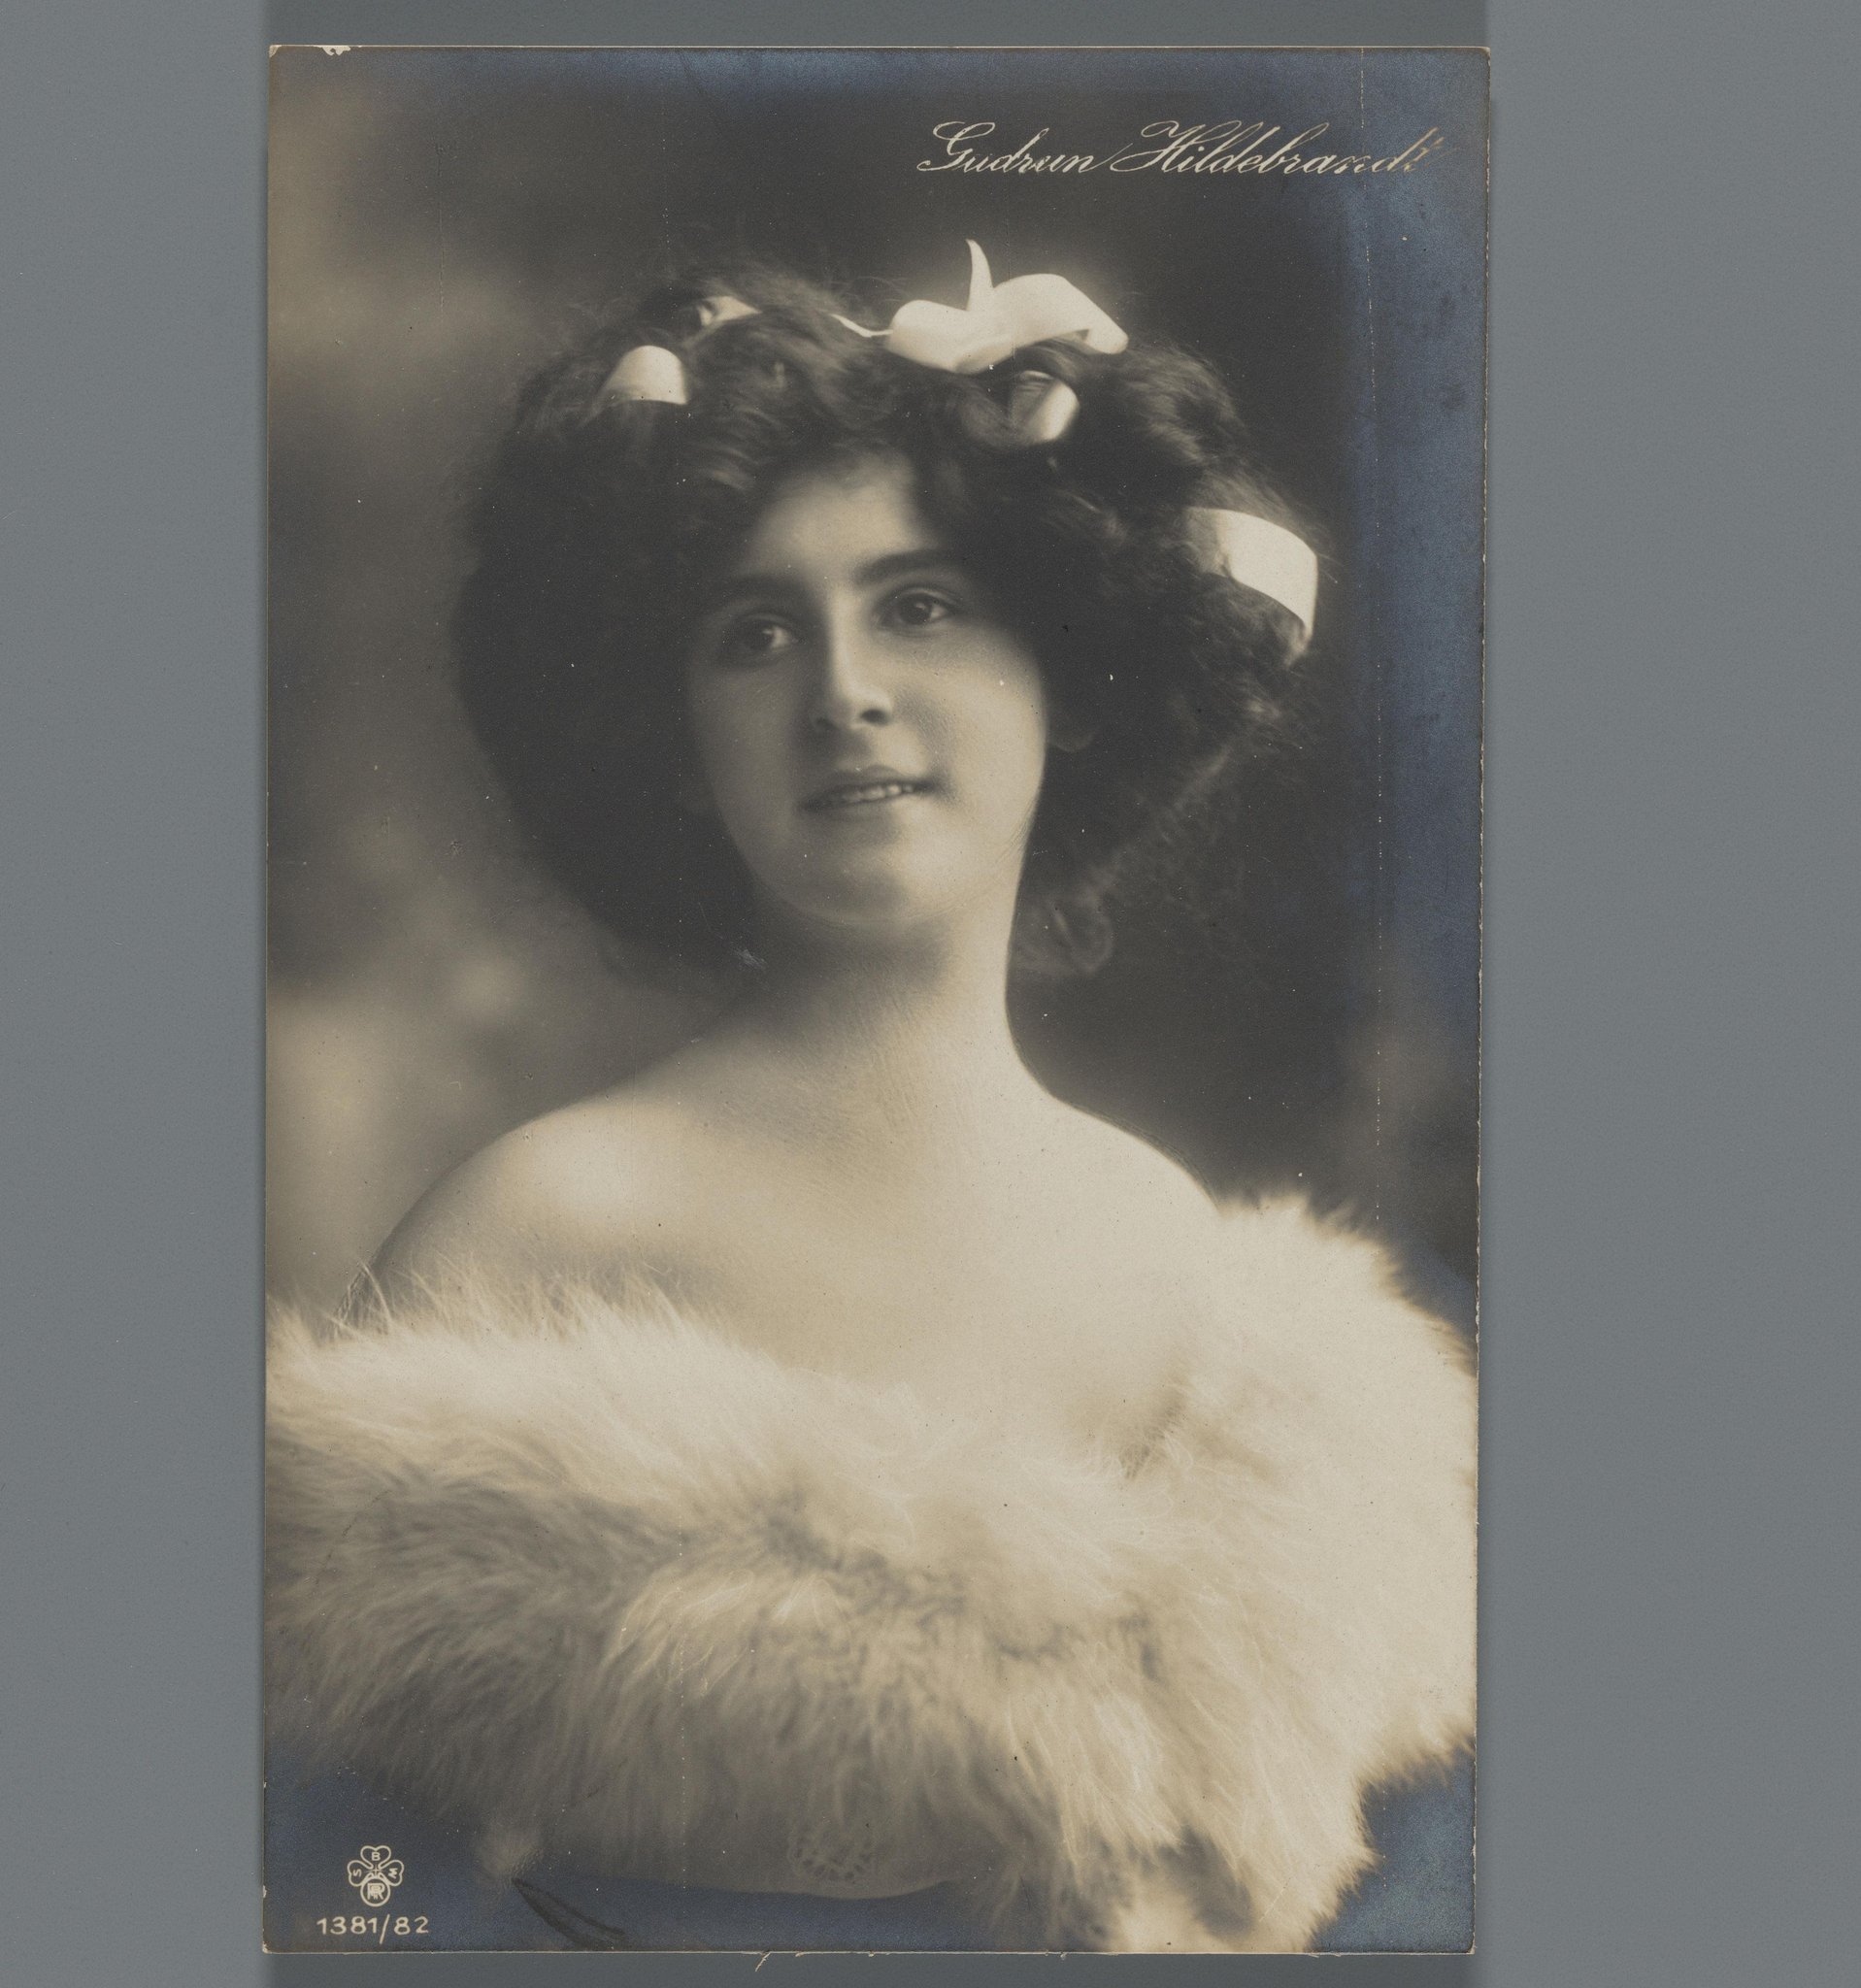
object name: photograph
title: Portret van Gudrun Hildebrandt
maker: Anonymous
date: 1900-1909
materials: paper, ink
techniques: gelatin silver print, pen, writing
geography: vienna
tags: portrait of actor, actress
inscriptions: inscription: ‘M A/ Anna van Aalst/ p.a. Mevrouw Sillenis/ Kerk-Avezaaht’, number: ‘1381/82’